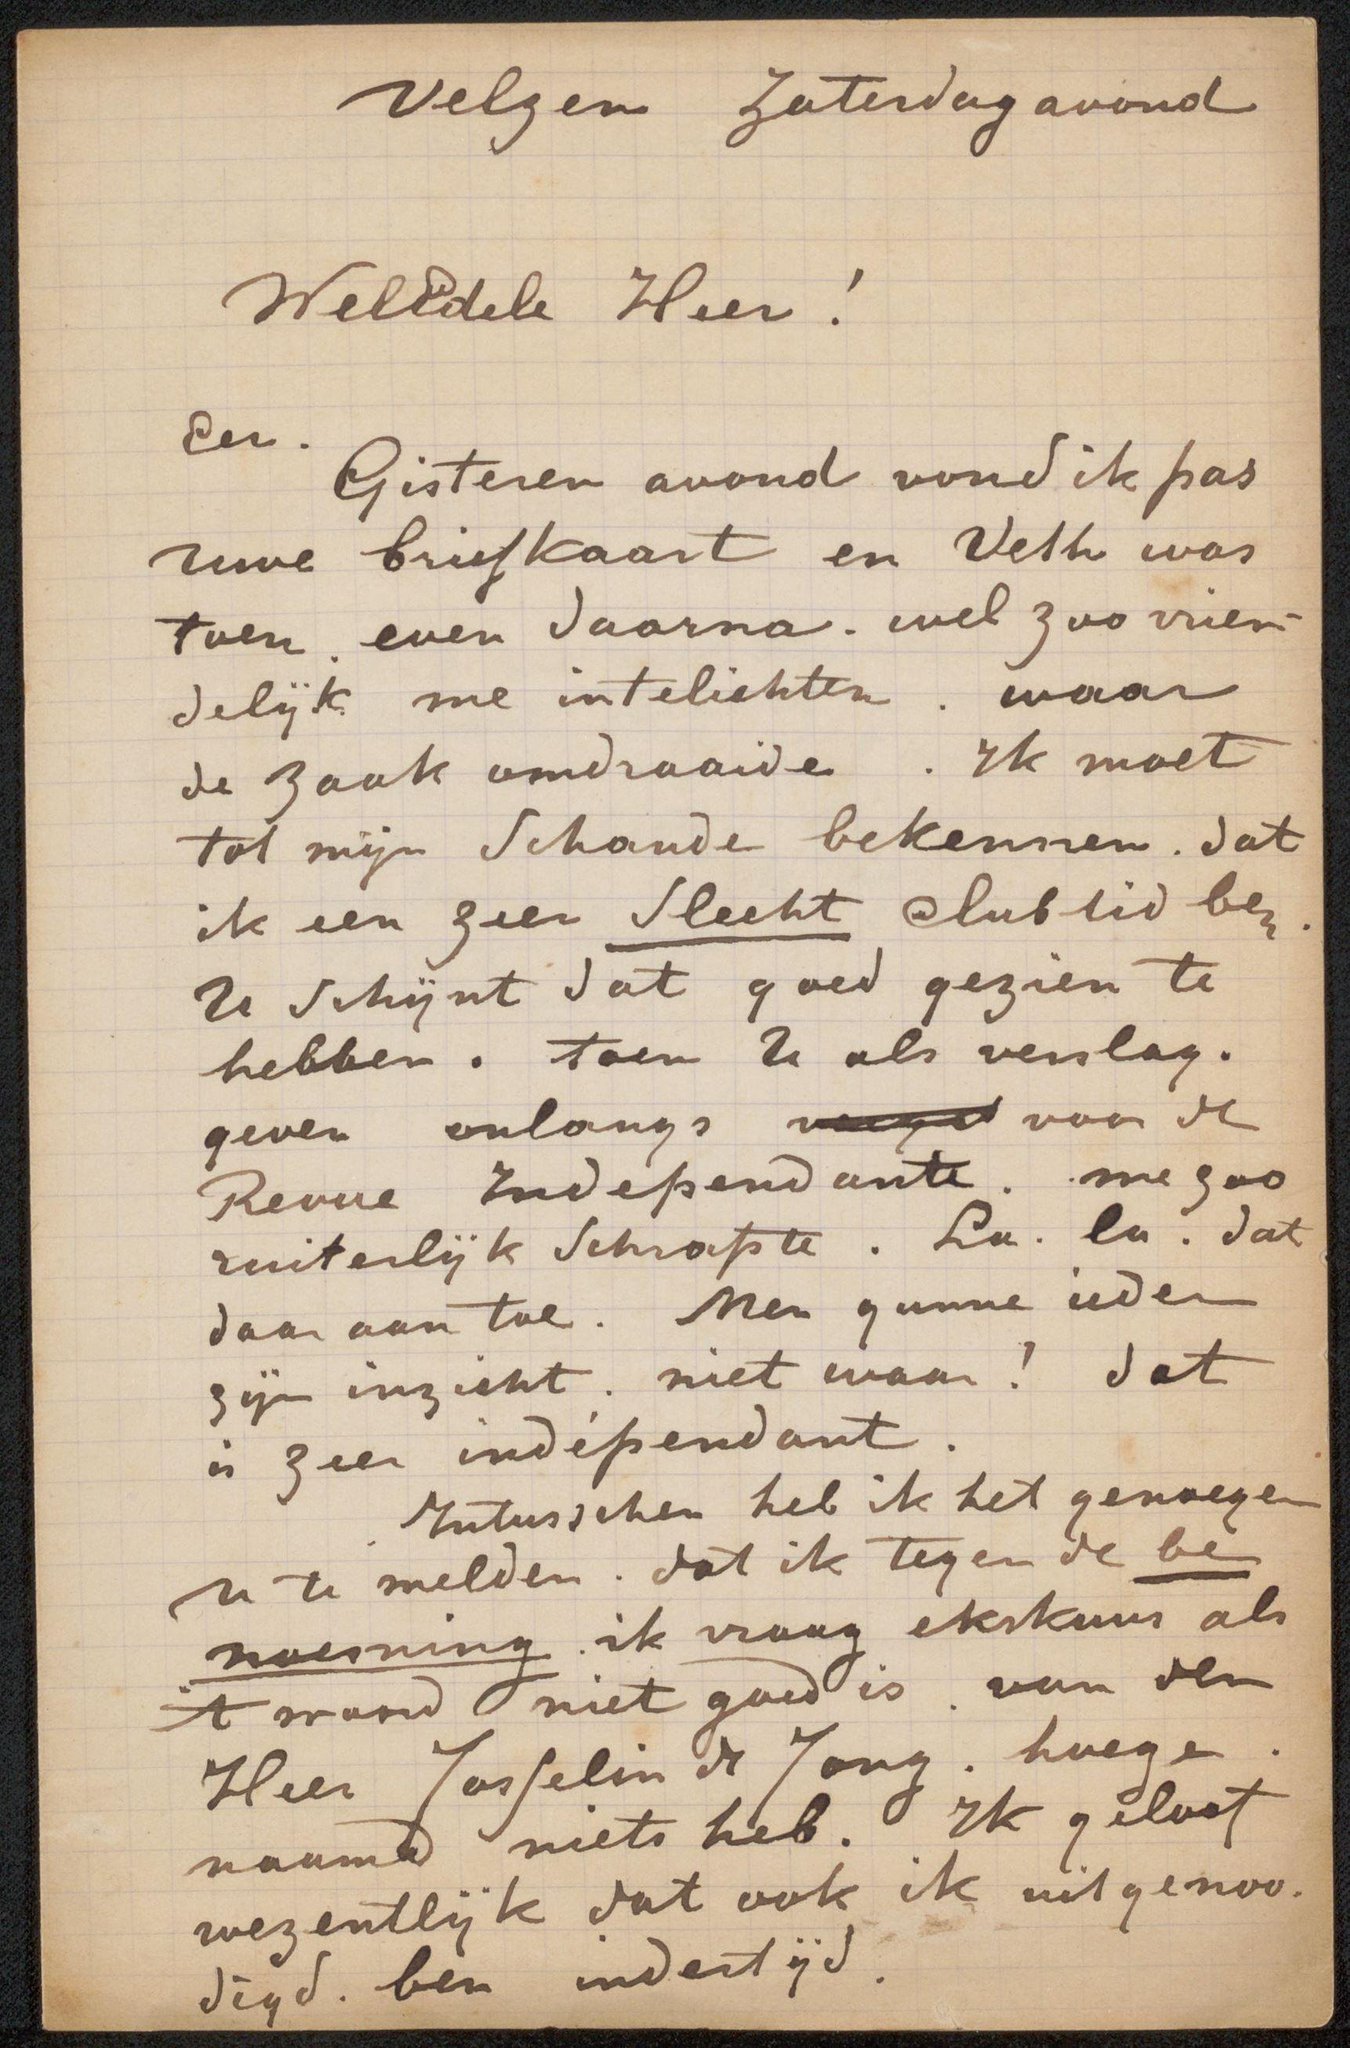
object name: letter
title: Brief aan Philip Zilcken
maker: jac van looij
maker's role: draughtsman, painter, print maker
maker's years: 1855-1930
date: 1865-1930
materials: ink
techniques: pen, writing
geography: velzen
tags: dordrecht, amsterdam, designer, jan veth, philip zilcken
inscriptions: collector's mark: ‘RPK’